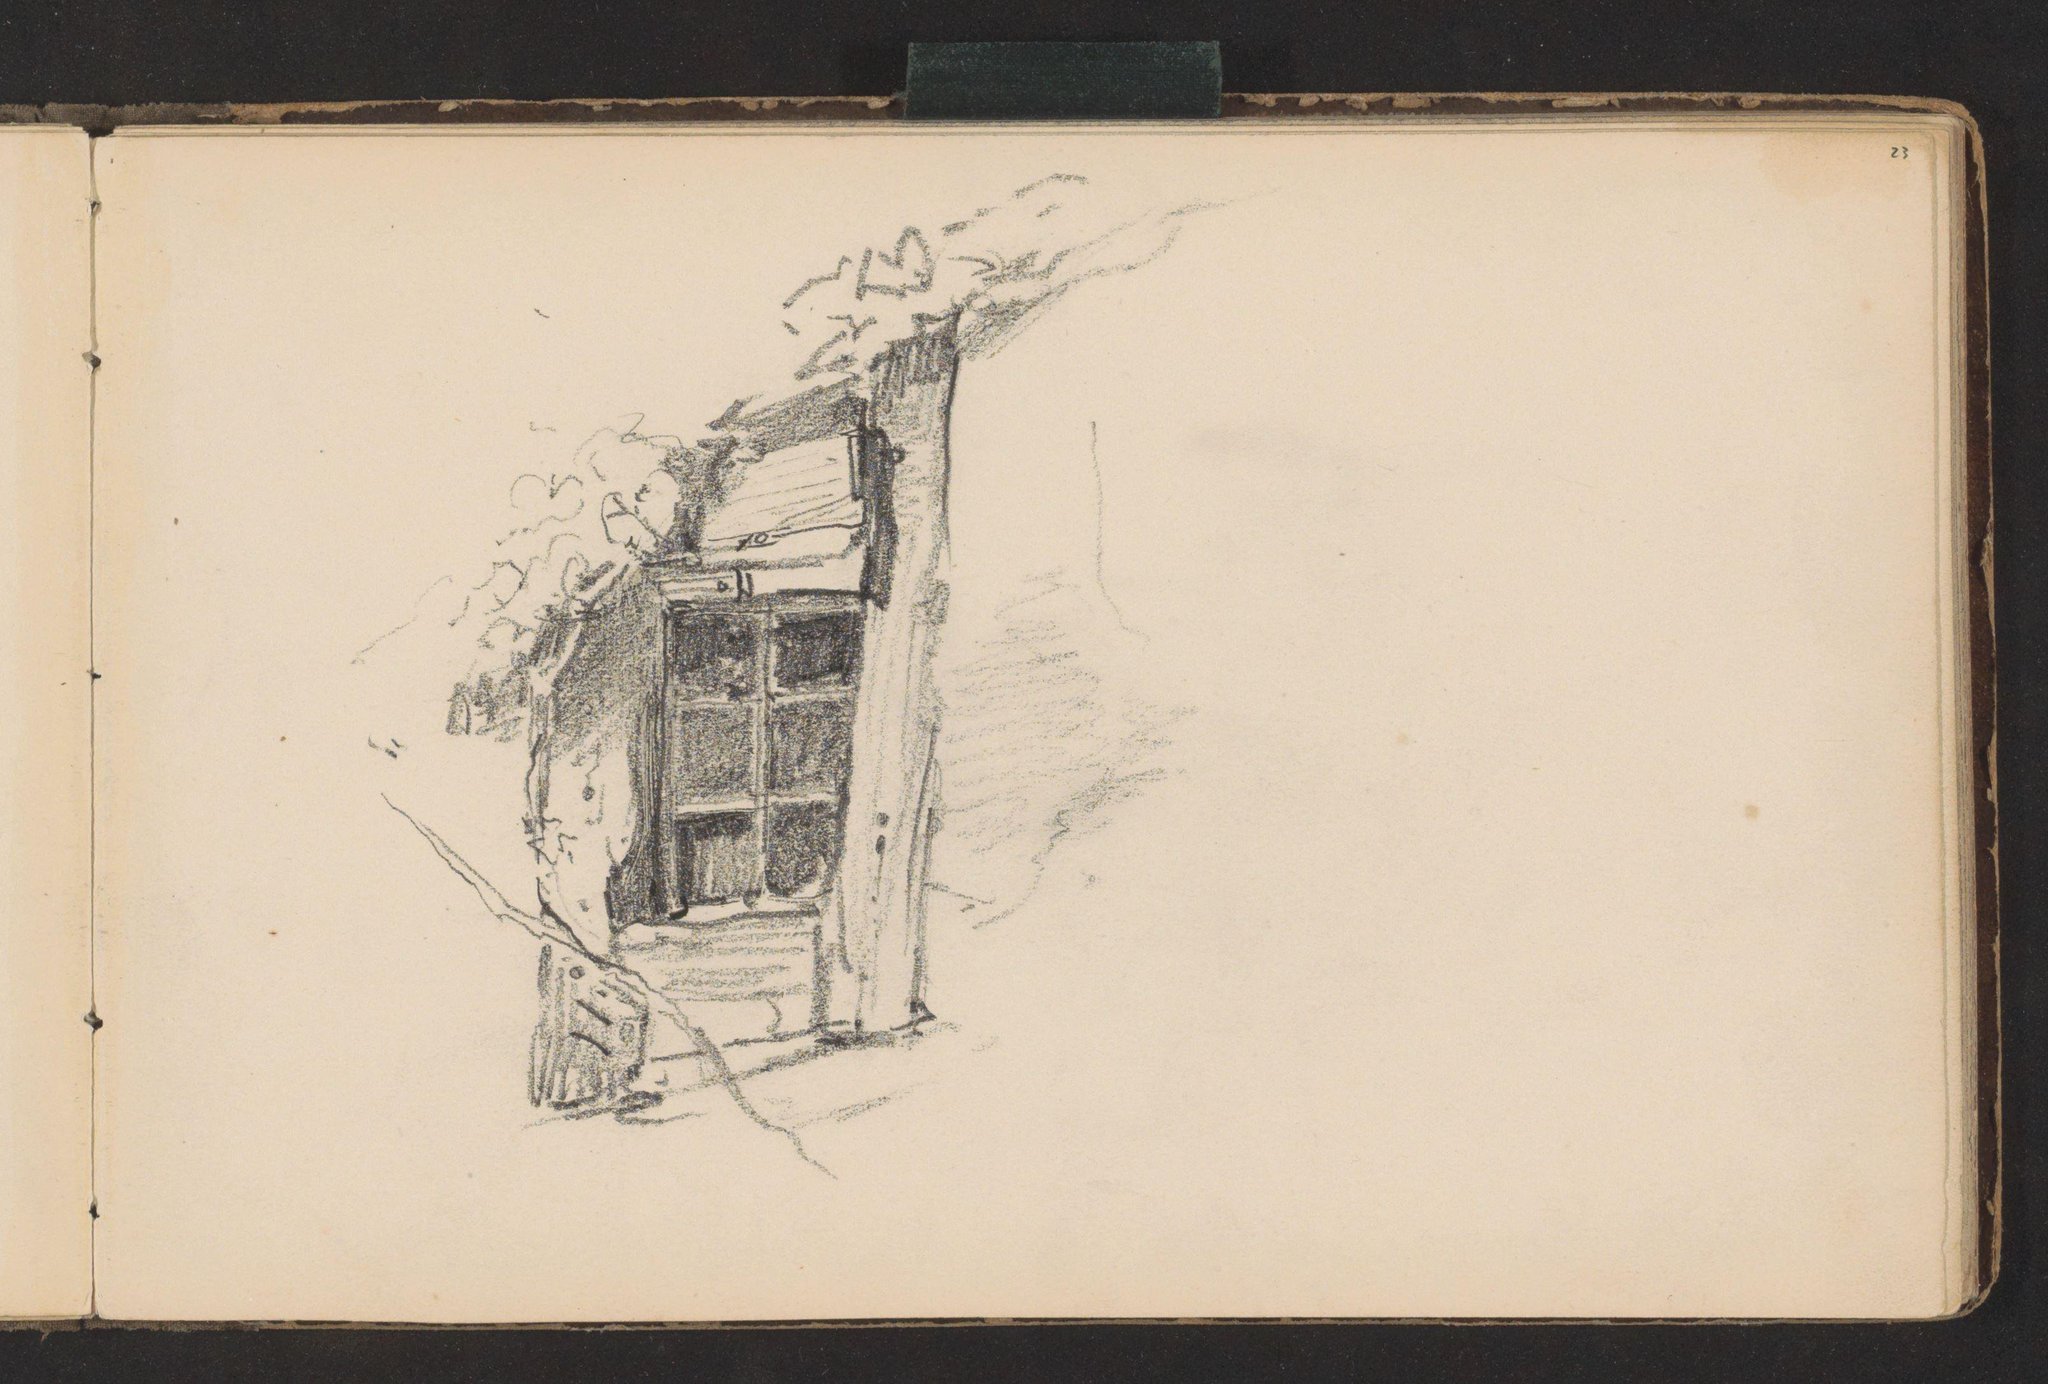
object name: sketchbook leaf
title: Plattelandswoning met een raam met rasterwerk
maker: maria vos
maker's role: draughtsman, painter, print maker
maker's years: 1824-1906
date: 1871-1878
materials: paper, pencil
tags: window, rural housing, e.g. country-house, villa, cottage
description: Blad 23 recto uit een schetsboek met 45 bladen.